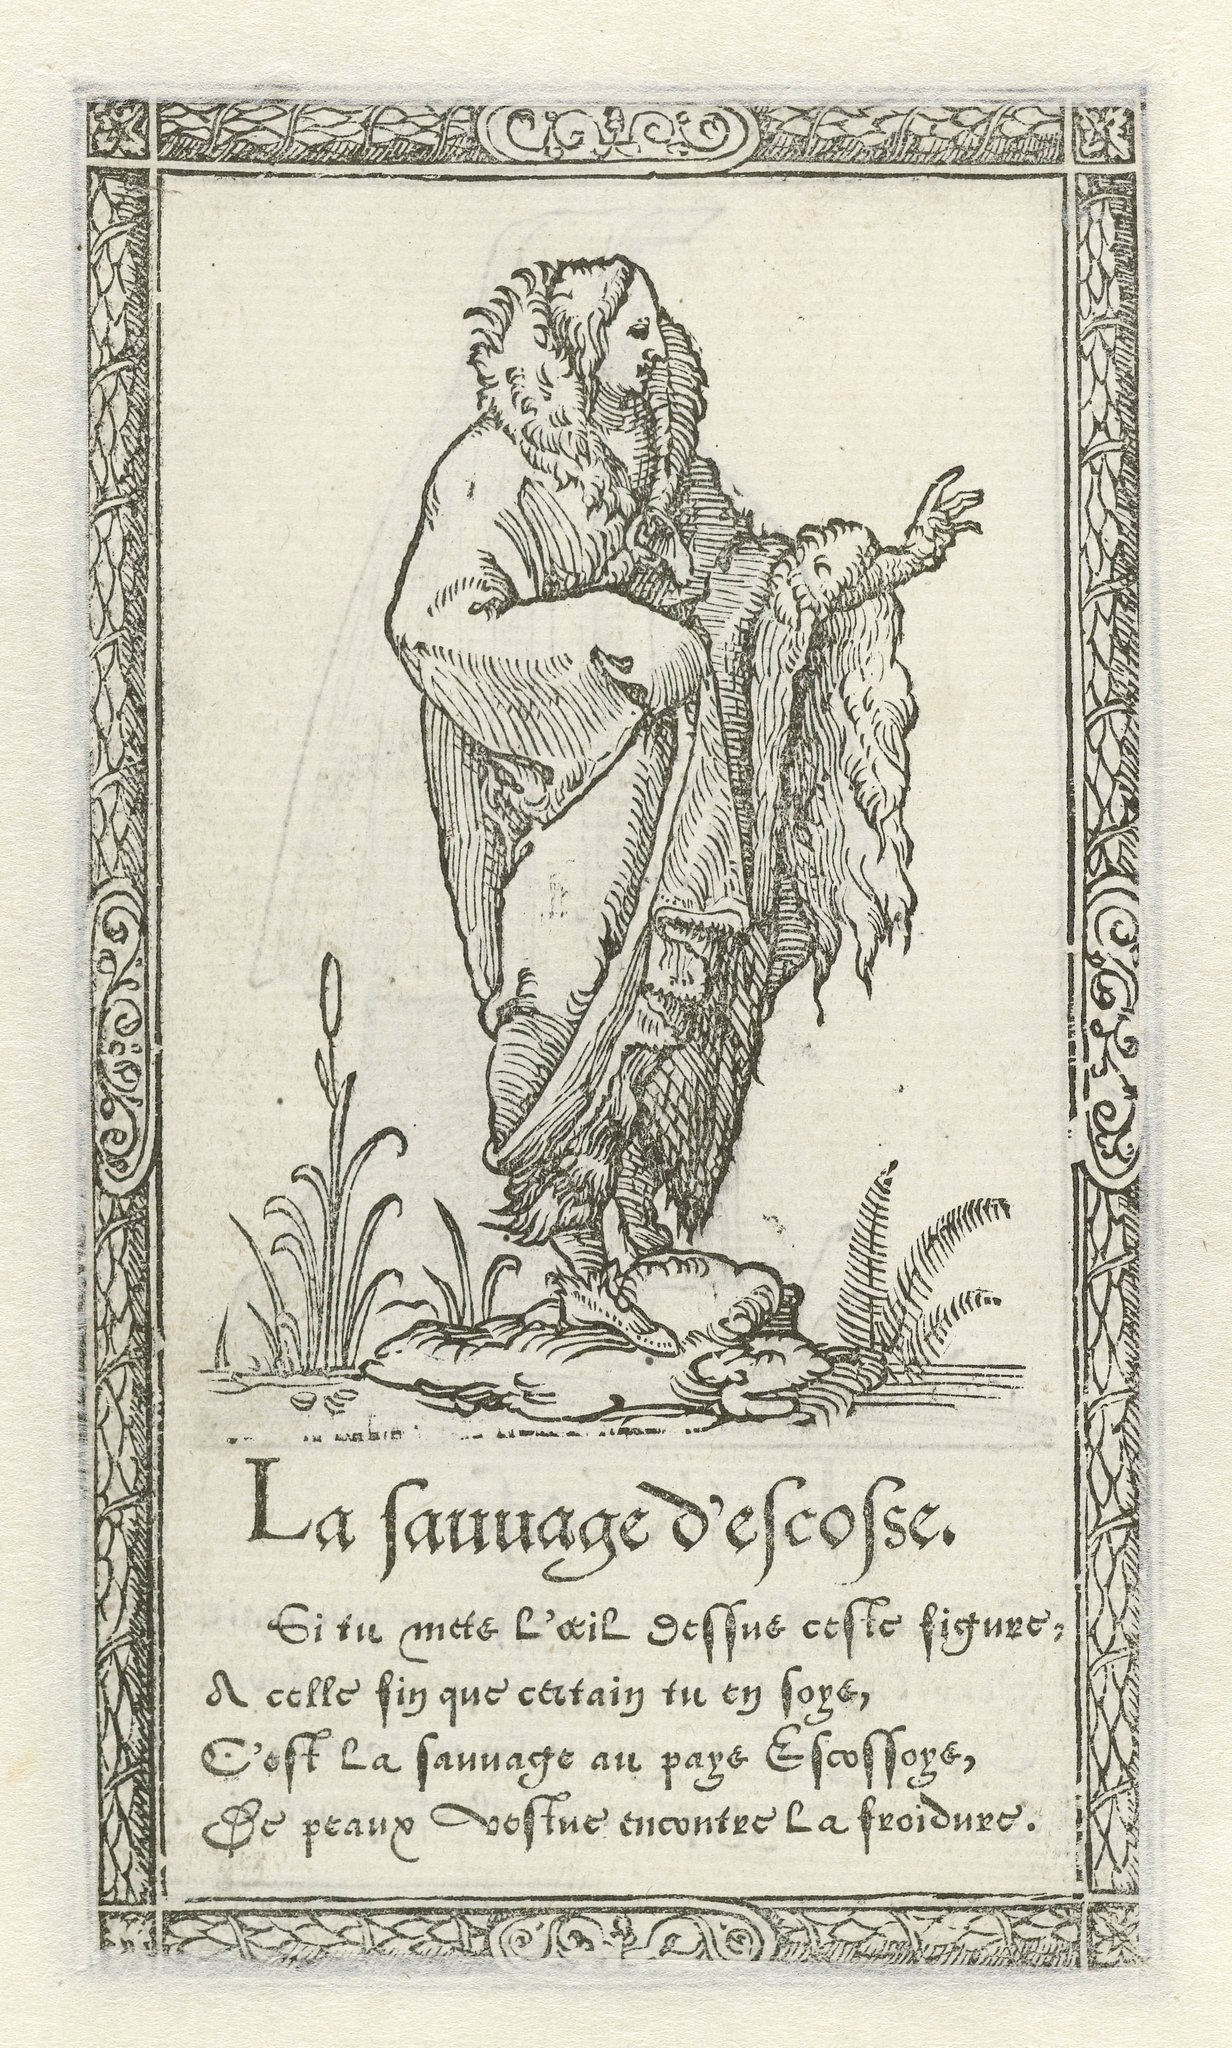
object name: print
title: La sauvage d'escosse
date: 1562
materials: paper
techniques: woodcut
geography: paris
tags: europeans (with name), clothed in rags, fashion plates, the poor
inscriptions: collector's mark: Lugt 2228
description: Dit is prent 36 uit een serie van 121. Binnen deze serie zijn er prenten gemaakt naar voorbeelden van Jean-François de Roberval en Enea Vico, onbekend welke precies.